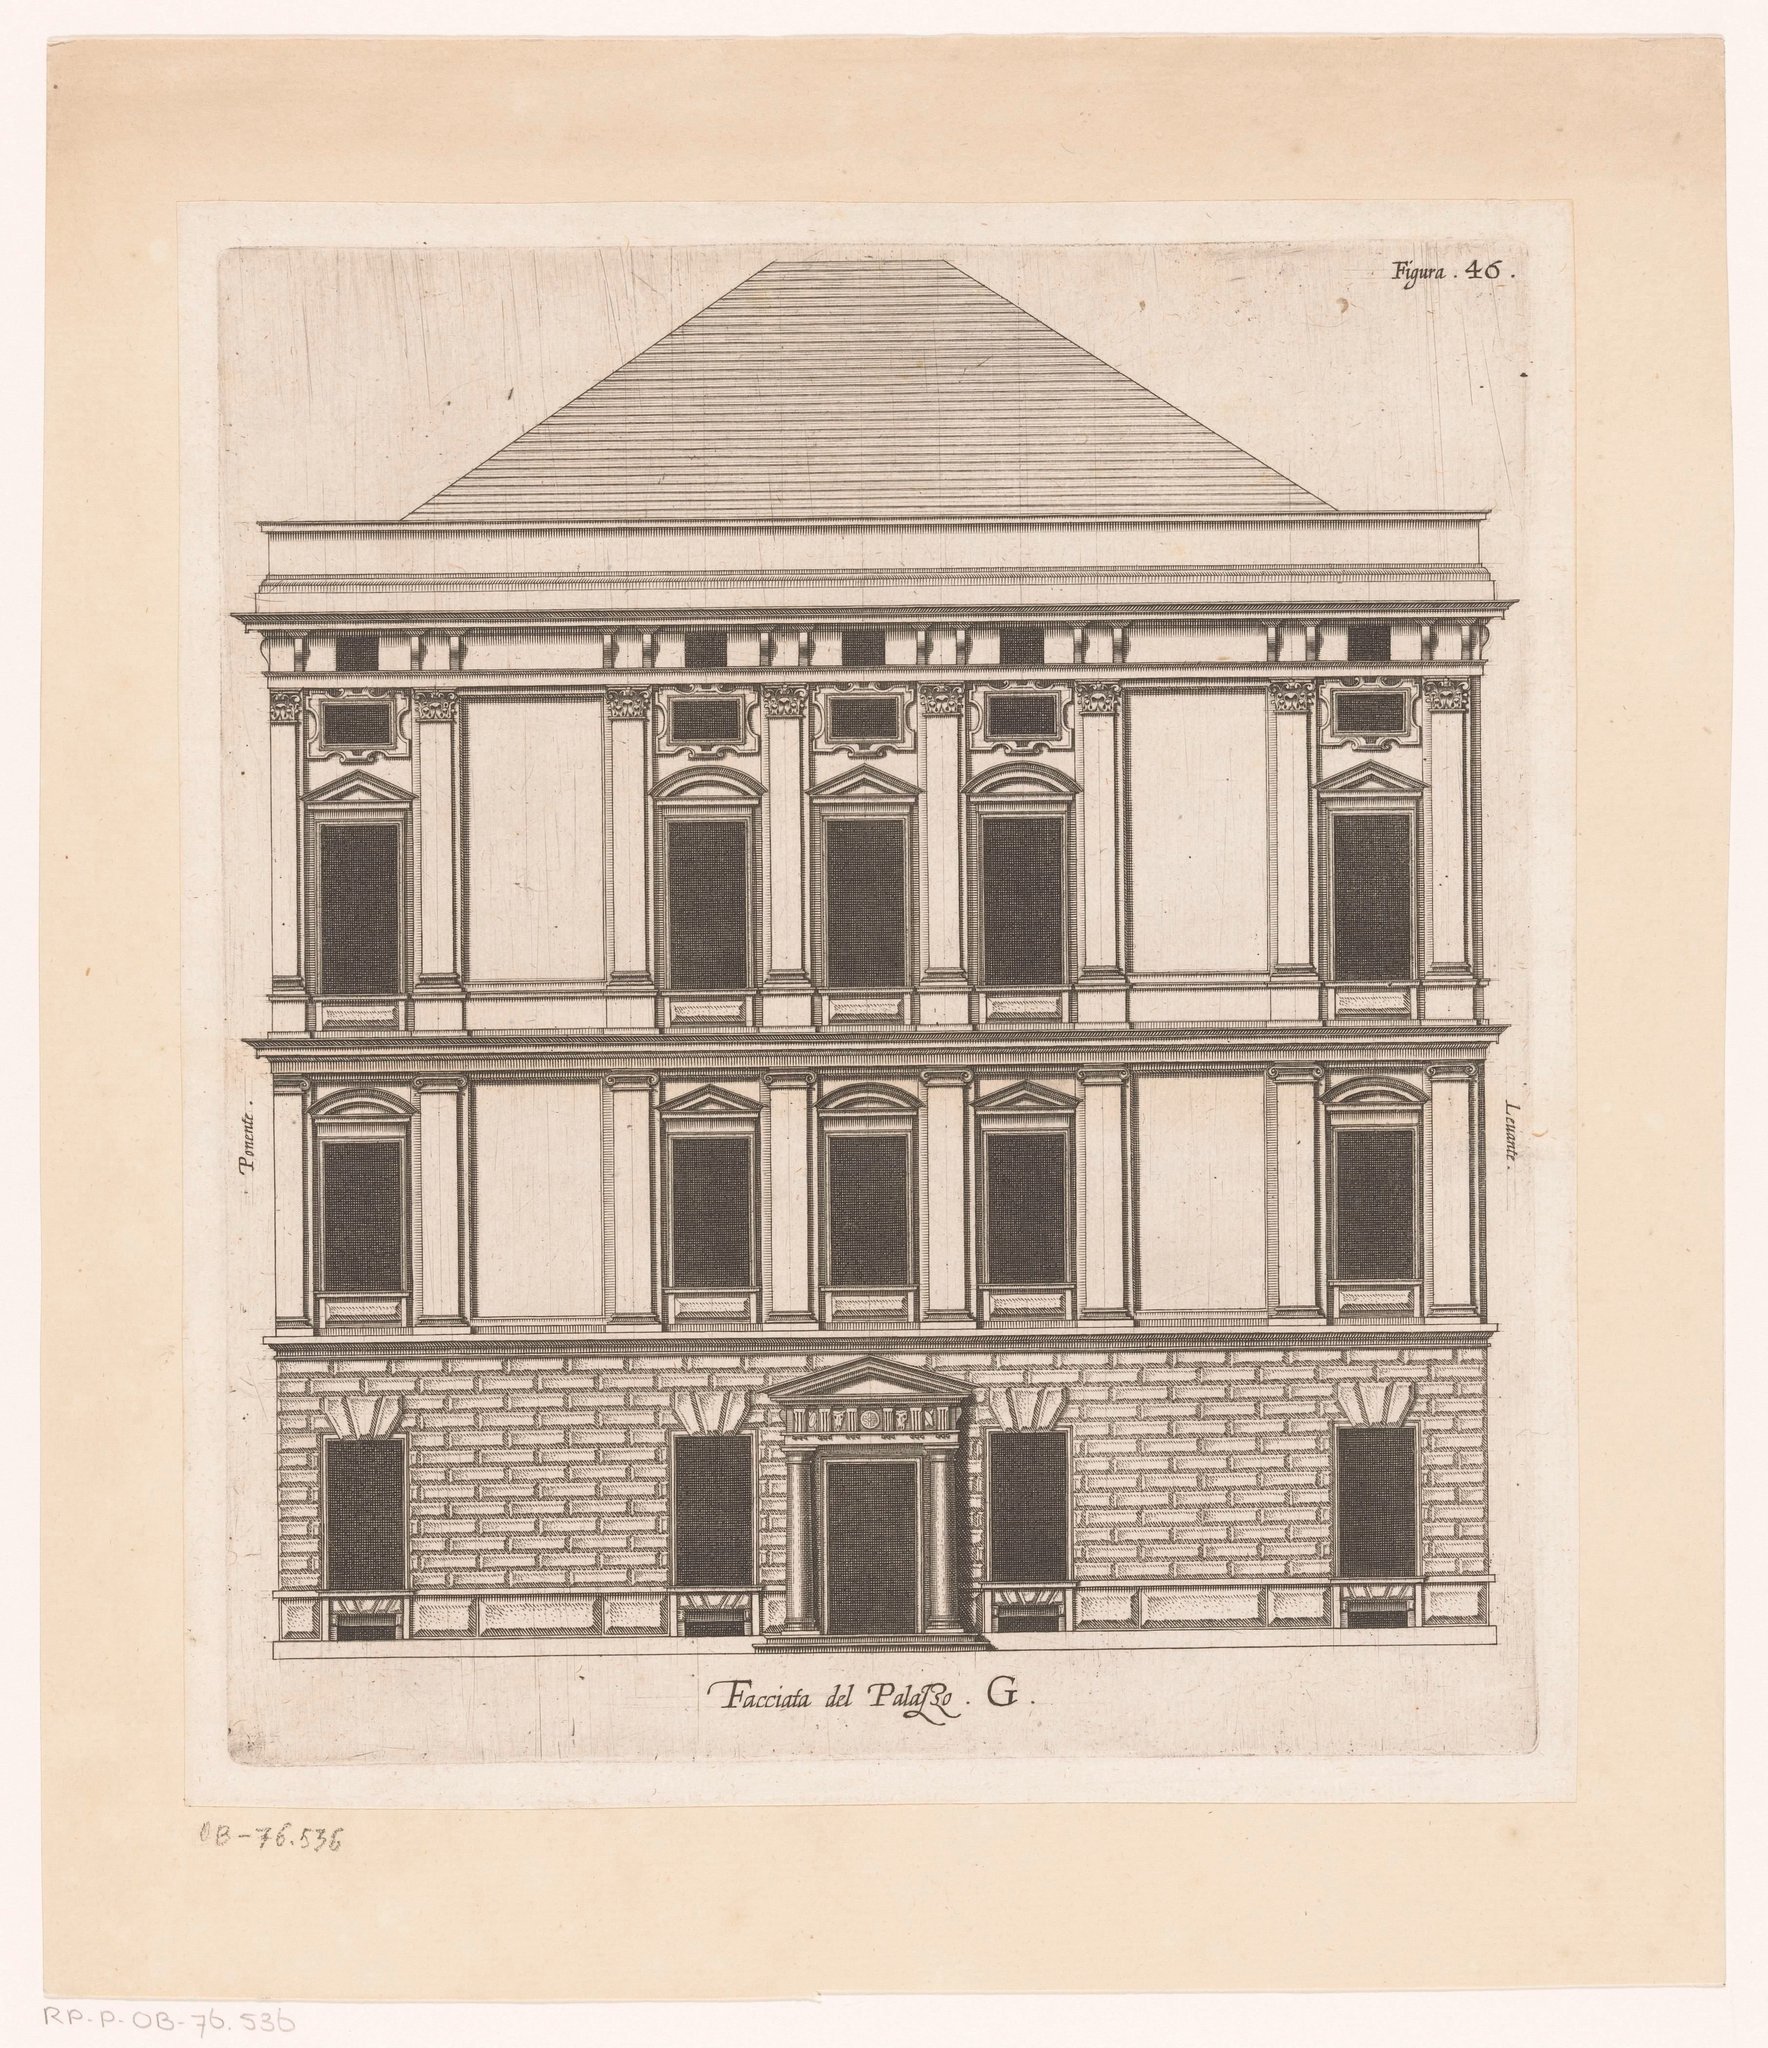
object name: ornament print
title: Facciata del Palazzo. G.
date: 1622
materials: paper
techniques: engraving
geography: antwerp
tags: hôtel, i.e. small palace in city, exterior ~ architectural design or model, front façade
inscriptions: collector's mark: Lugt 240